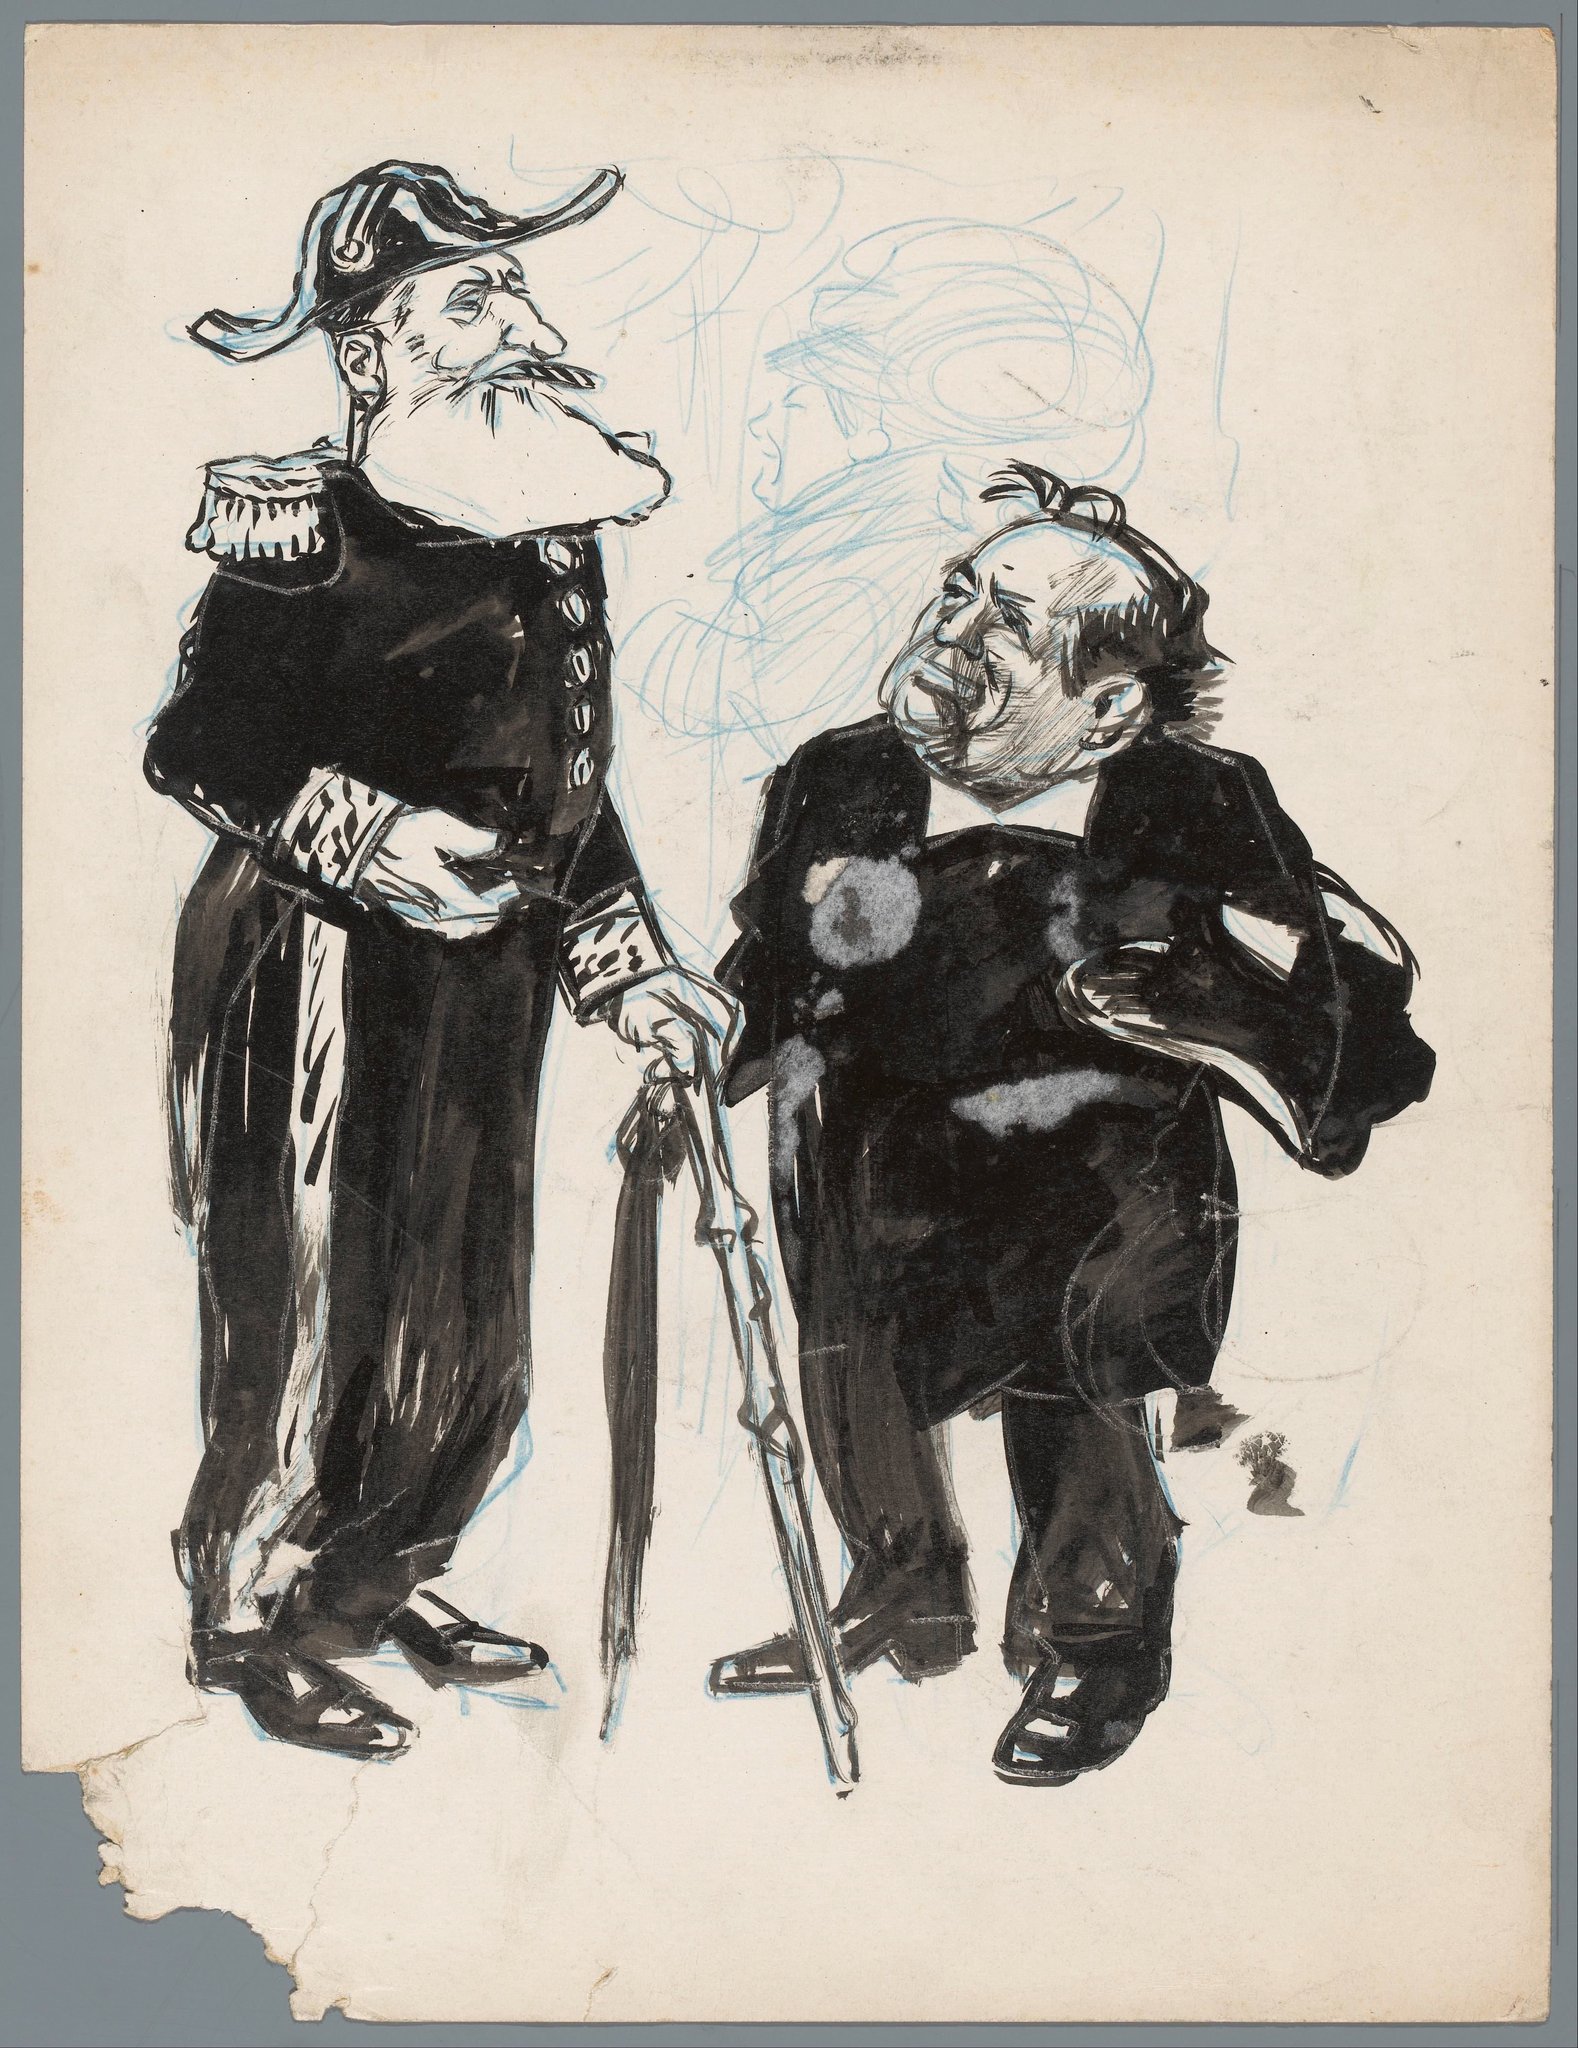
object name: cartoon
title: Twee politici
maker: patricq kroon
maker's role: draughtsman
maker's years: 1862-1941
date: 1900-1935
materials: ink, paper, pencil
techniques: brush, pen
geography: netherlands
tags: political caricatures and satires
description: Twee politici (een minister en Abraham Kuyper?) met elkaar in gesprek. Ontwerp voor een politieke spotprent.